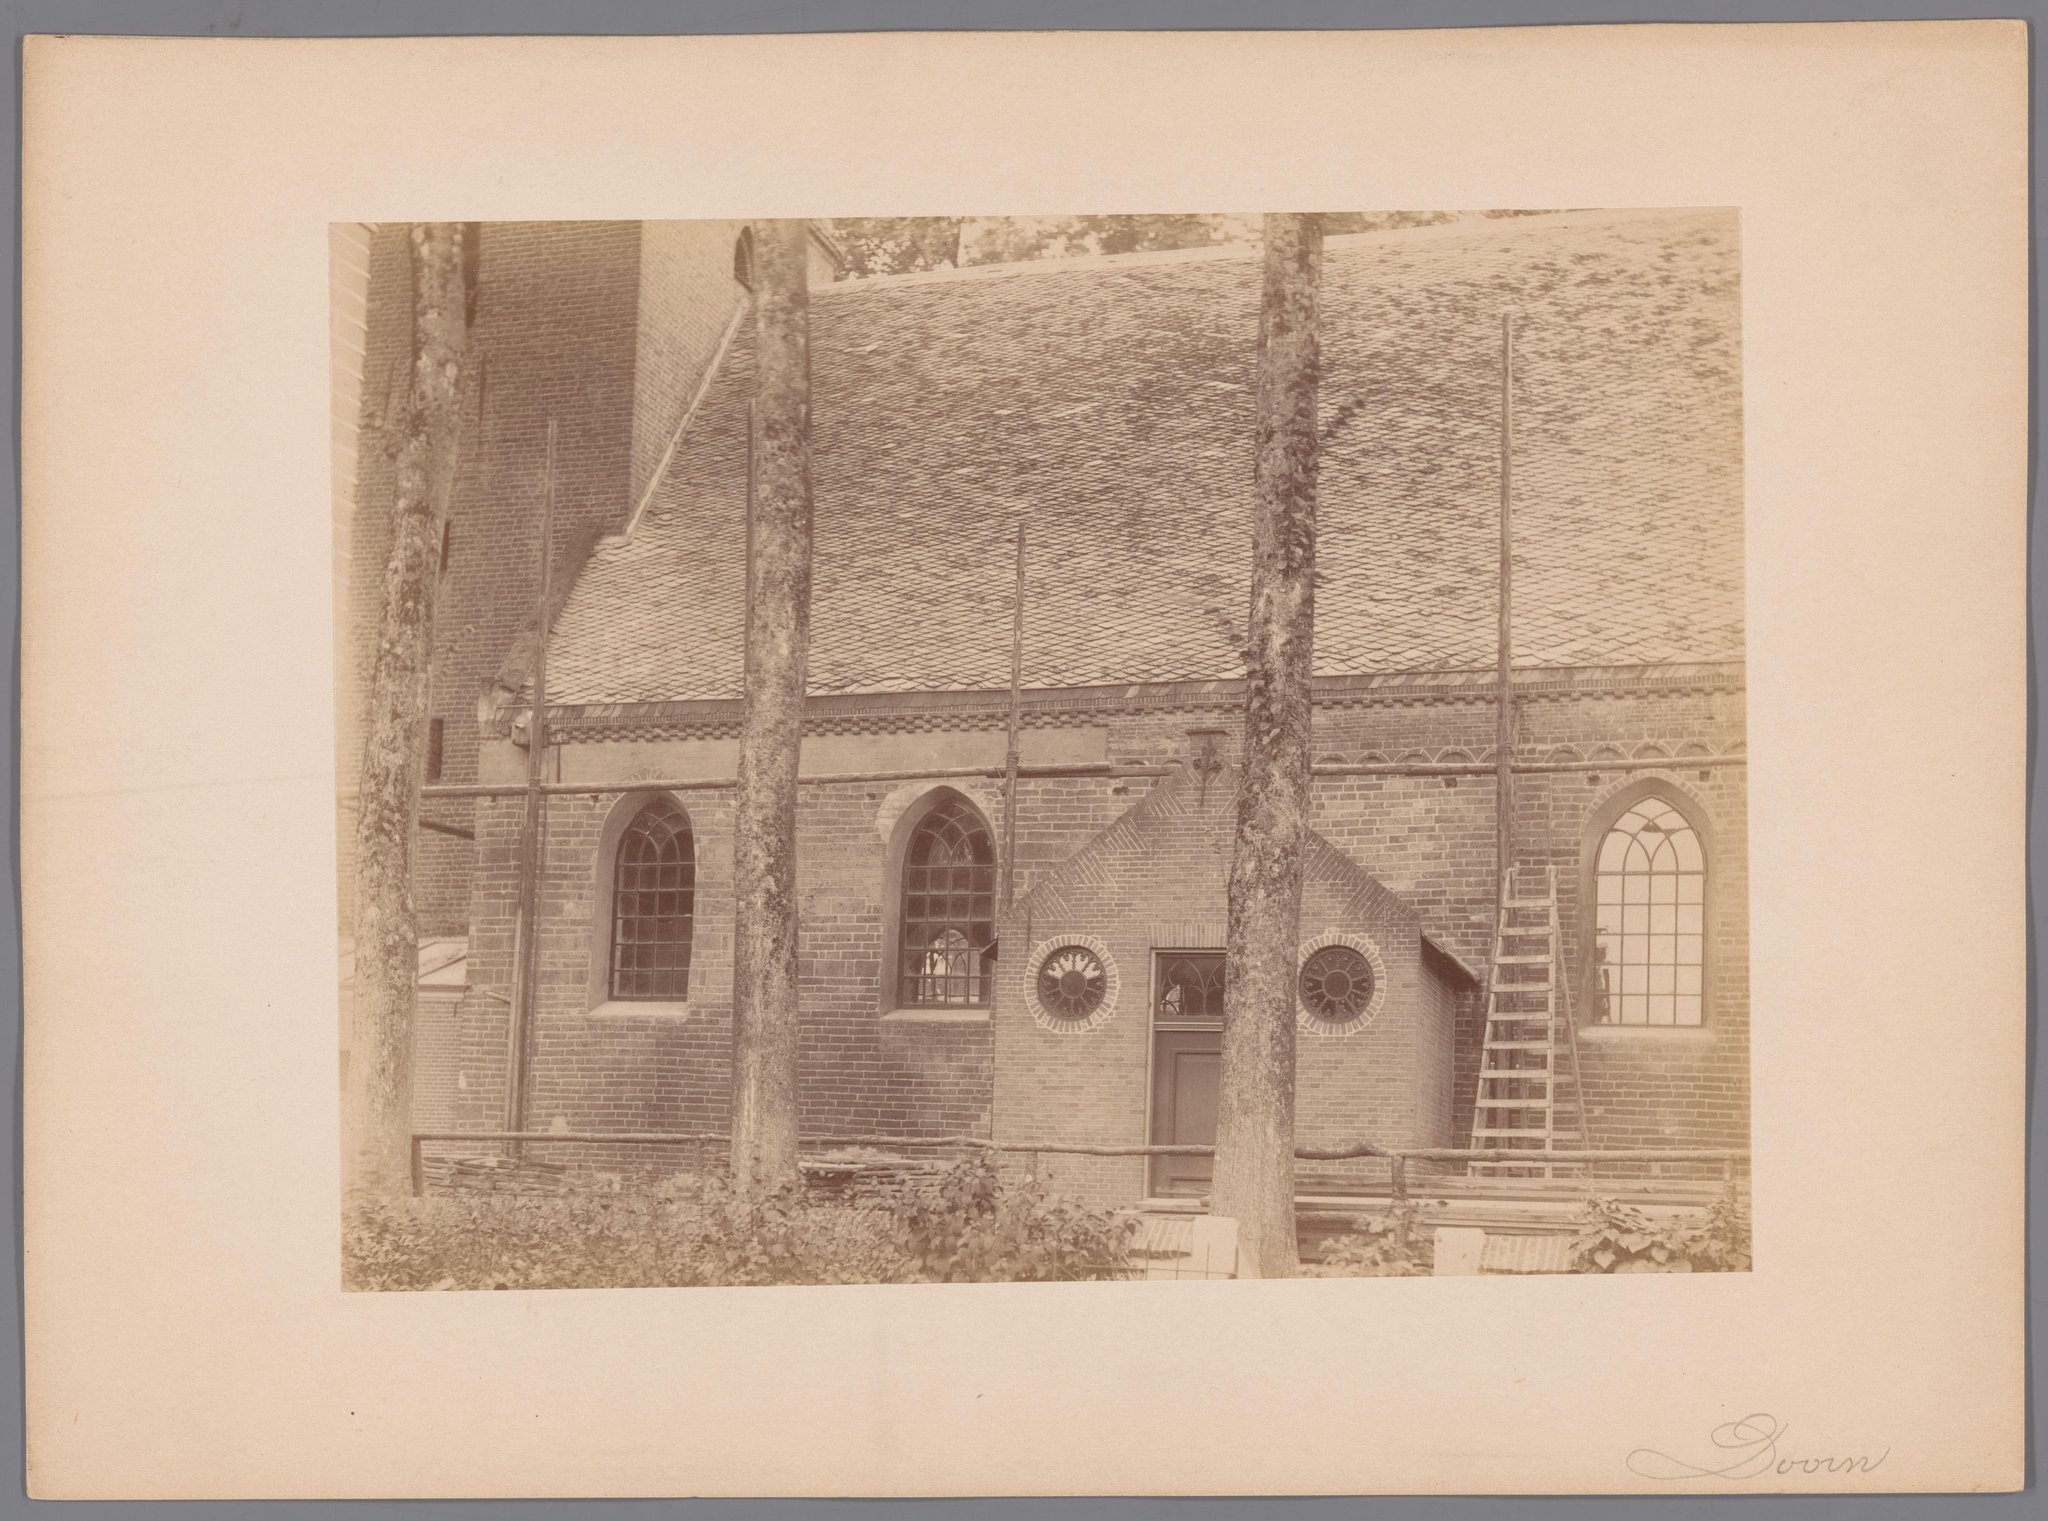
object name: photograph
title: Zuidzijde van de Maartenskerk te Doorn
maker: anoniem (monumentenzorg)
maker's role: fotograaf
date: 1890-1920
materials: cardboard, photographic support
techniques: albumen print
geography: doorn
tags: church (exterior)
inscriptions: annotation: ‘Doorn’, annotation: ‘Doorn/ N.H. Kerk/ Zuid-zijde’